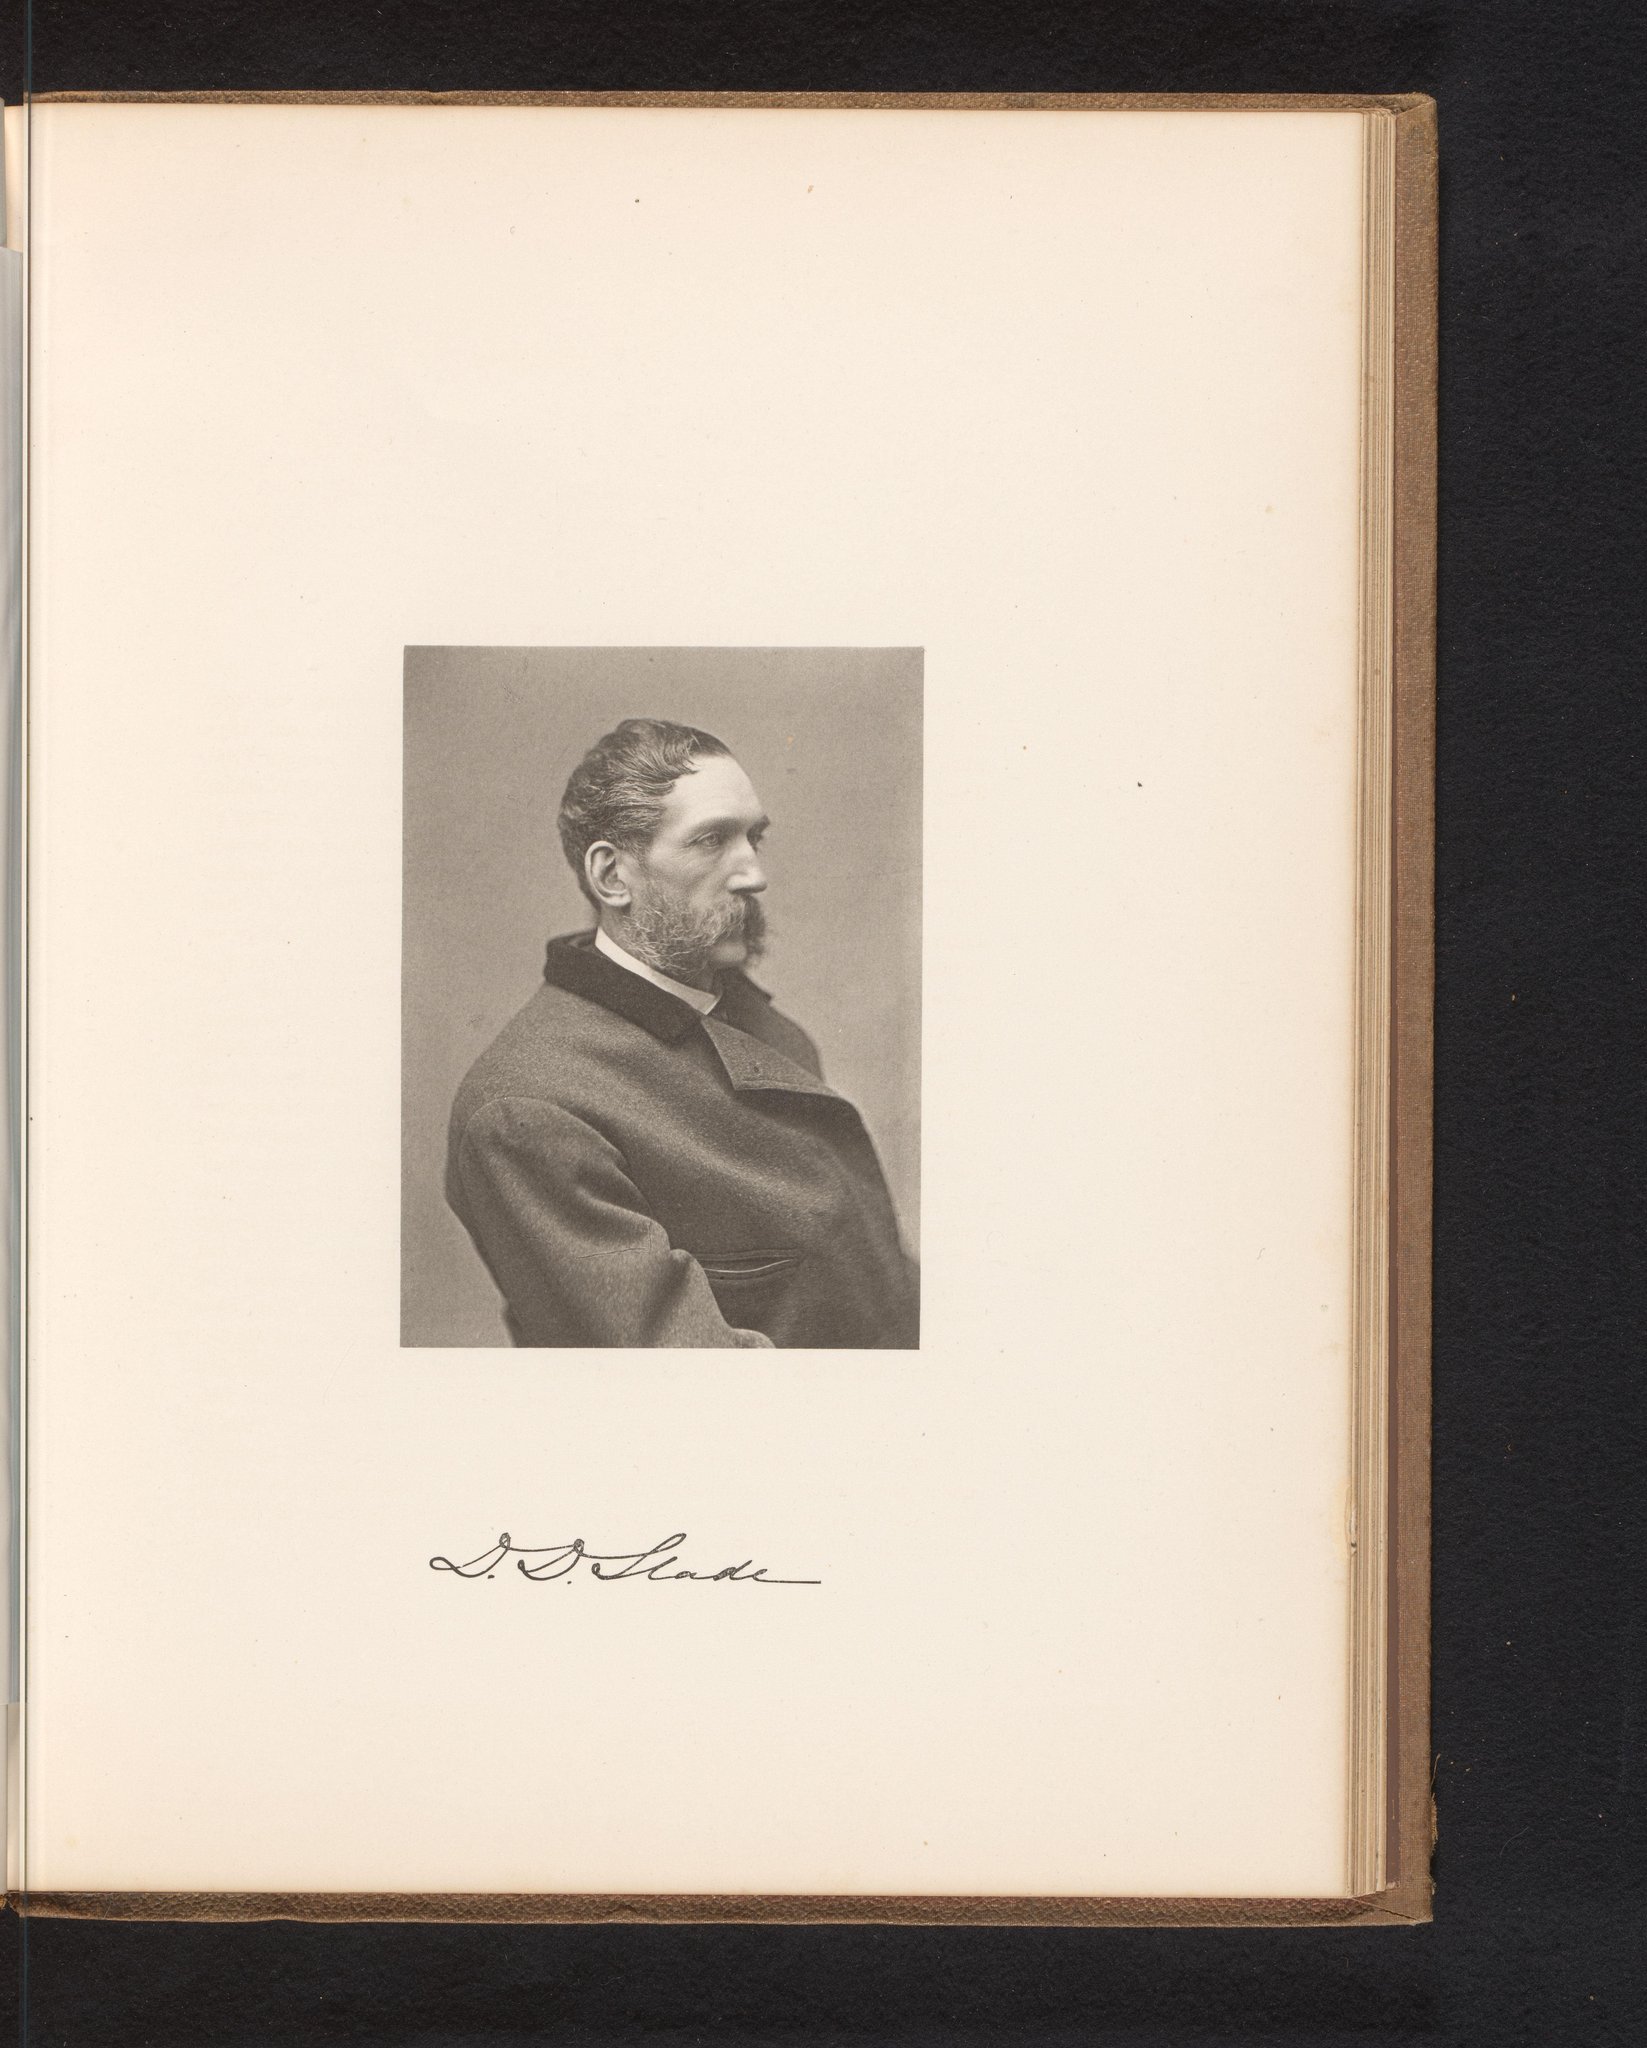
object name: page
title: D.D. Slade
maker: Anonymous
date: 1870-1875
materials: paper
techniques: photograph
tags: historical persons, professor